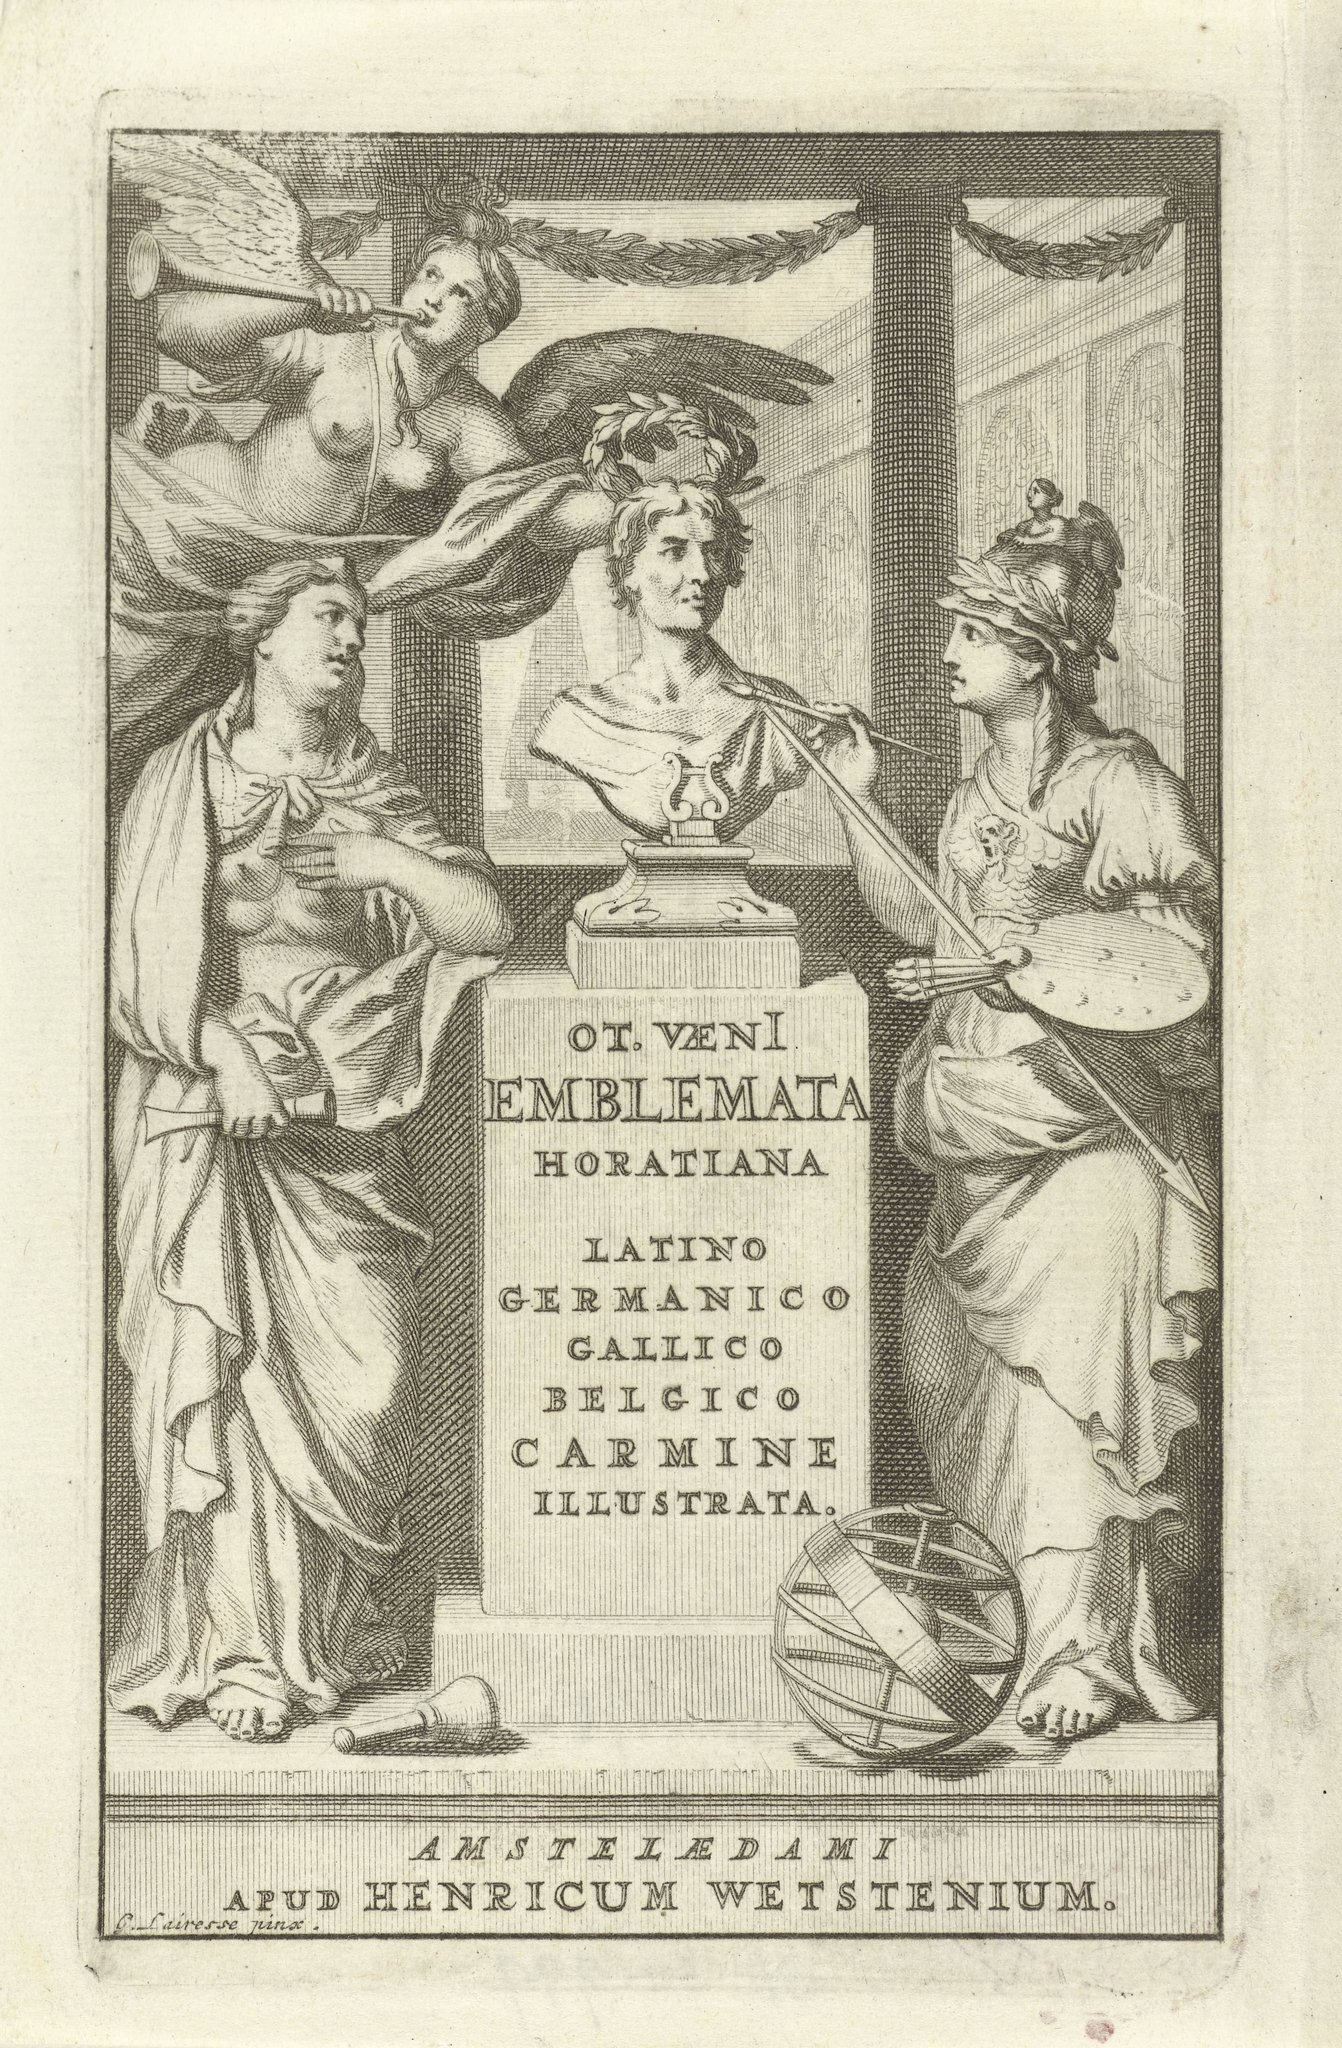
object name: print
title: Titelpagina voor Otto van Veen, Emblemata Horatiana, 1684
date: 1684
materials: paper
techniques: engraving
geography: amsterdam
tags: leiden, painter, draughtsman, otto van veen, 'pictura', symbolic representations, allegories and emblems ~ painting; 'pittura' (ripa), 'sculptura', symbolic representations, allegories and emblems ~ sculpture; 'scoltura' (ripa), fame; 'fama', 'fama buona', 'fama chiara' (ripa)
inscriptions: collector's mark: Lugt 240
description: Titelpagina met in het midden een voetstuk met daarop de buste van de schilder Otto van Veen. De personificatie van de schilderkunst en de personificatie van de beeldhouwkunst rondom het beeld. Faam vliegt boven het beeld en kroont het met een lauwerkrans. Op het voetstuk de titel van het boekwerk.